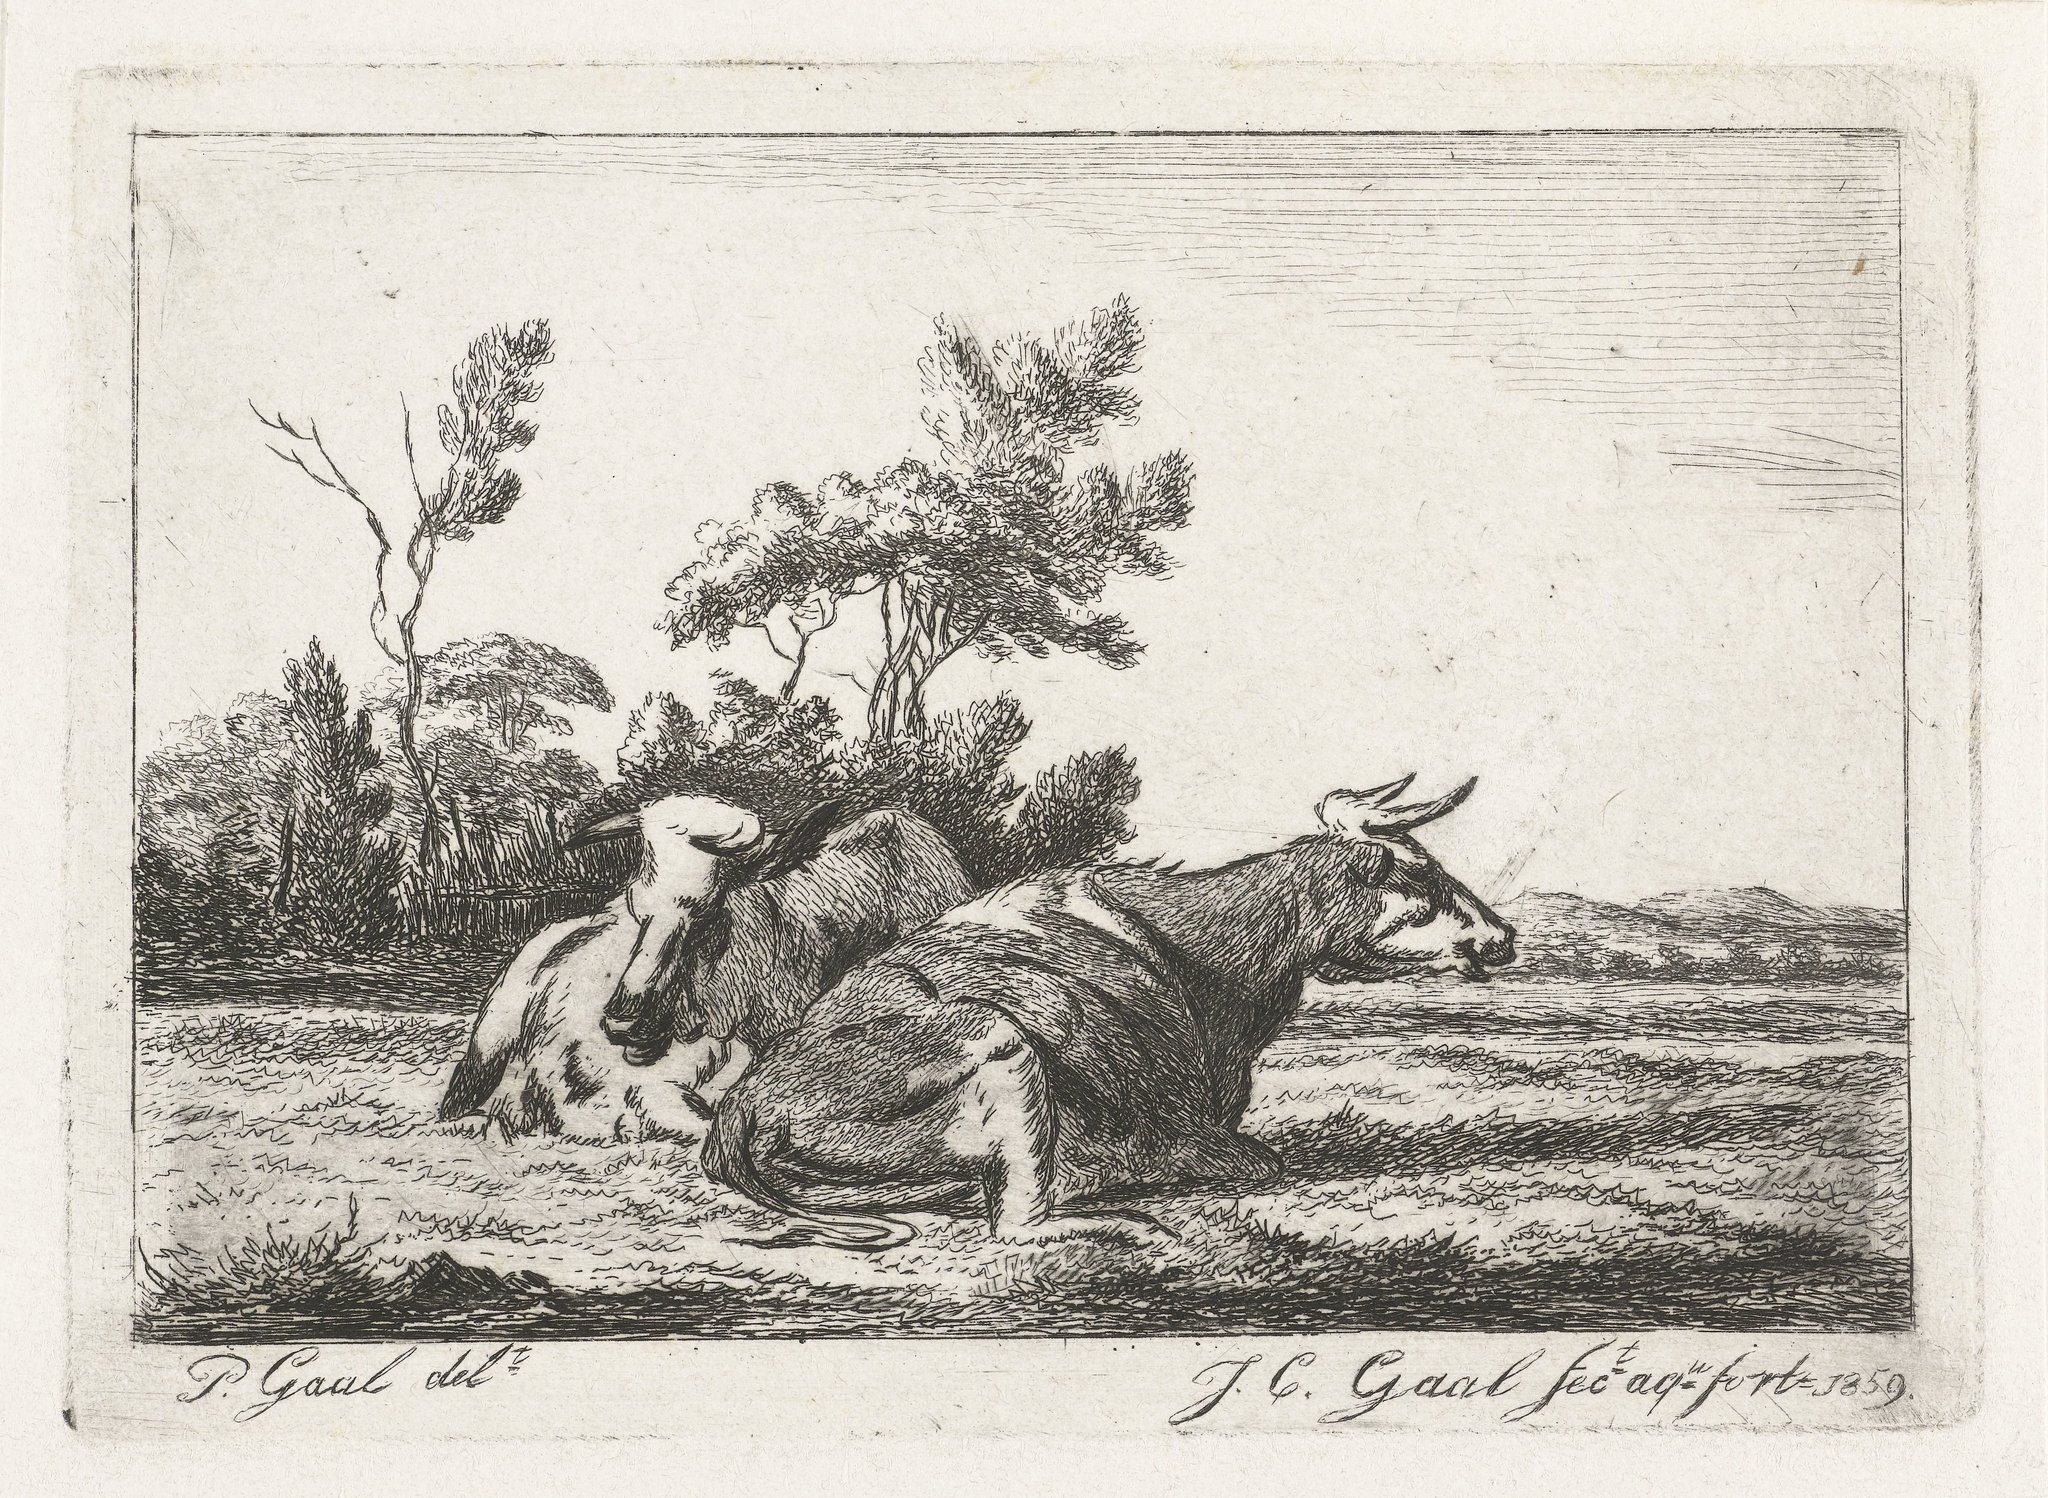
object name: print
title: Twee bonte koeien liggend voor een groepje bomen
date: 1859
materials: paper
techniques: etching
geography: netherlands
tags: cow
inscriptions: collector's mark: Lugt 2228